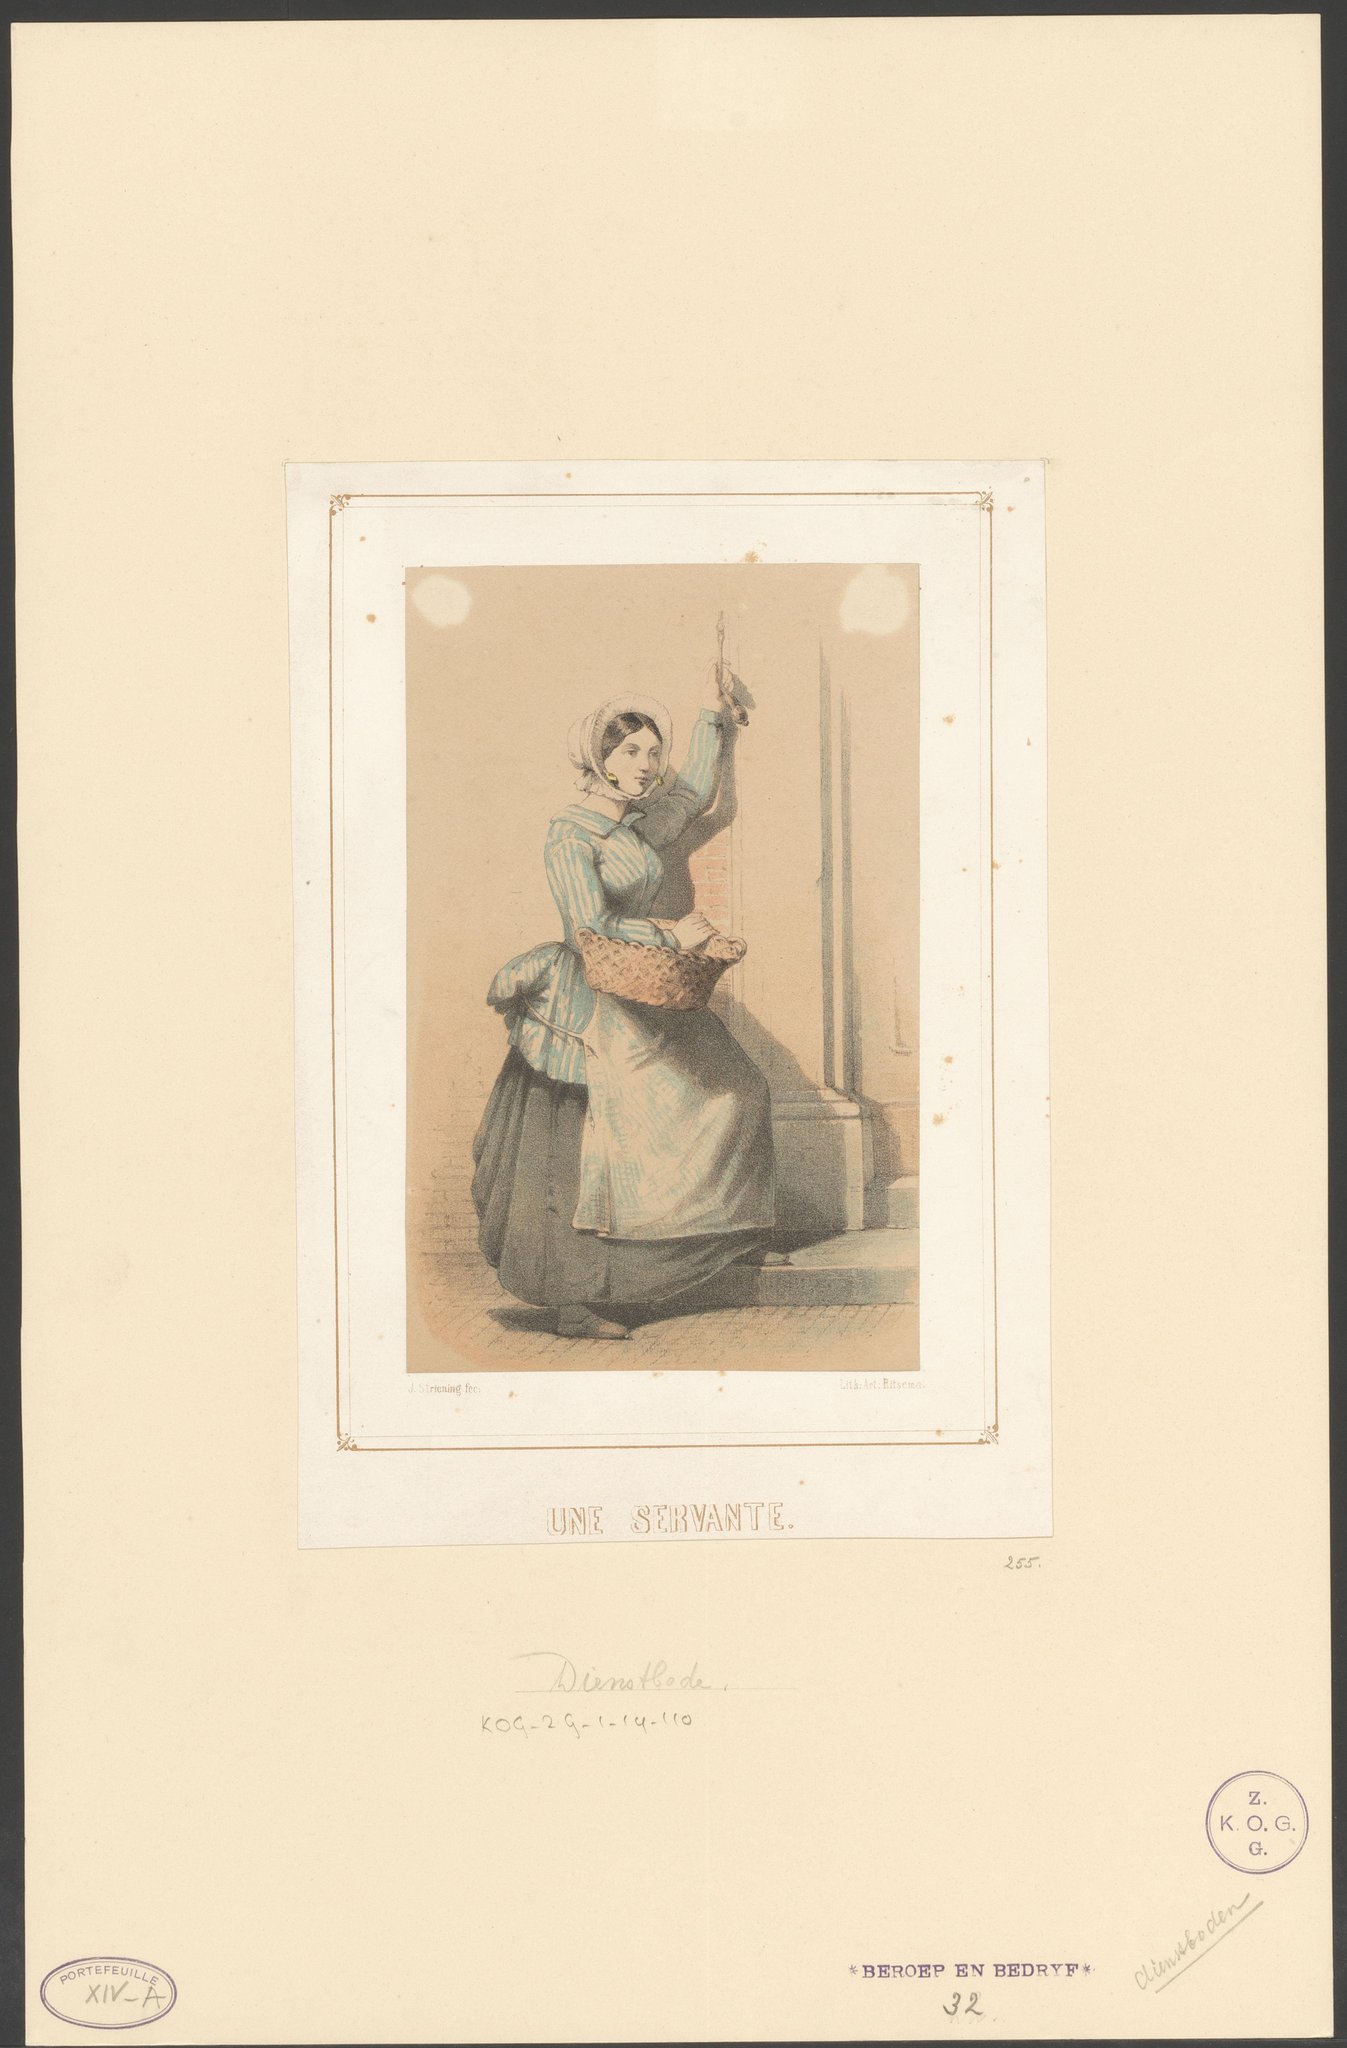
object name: print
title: Dienstbode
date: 1840-1903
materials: paper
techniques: lithograph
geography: netherlands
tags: door-knocker, doorbell, maid ~ house personnel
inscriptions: collector's mark: Lugt 1641, collector's mark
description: Dienstbode met een mand trekt aan de deurbel. Onderwerpsrubrieken binnen de Atlas Zeden en Gewoonten: Beroep en bedrijf. Vrouwelijk beroep en bedrijf. Dienstboden.